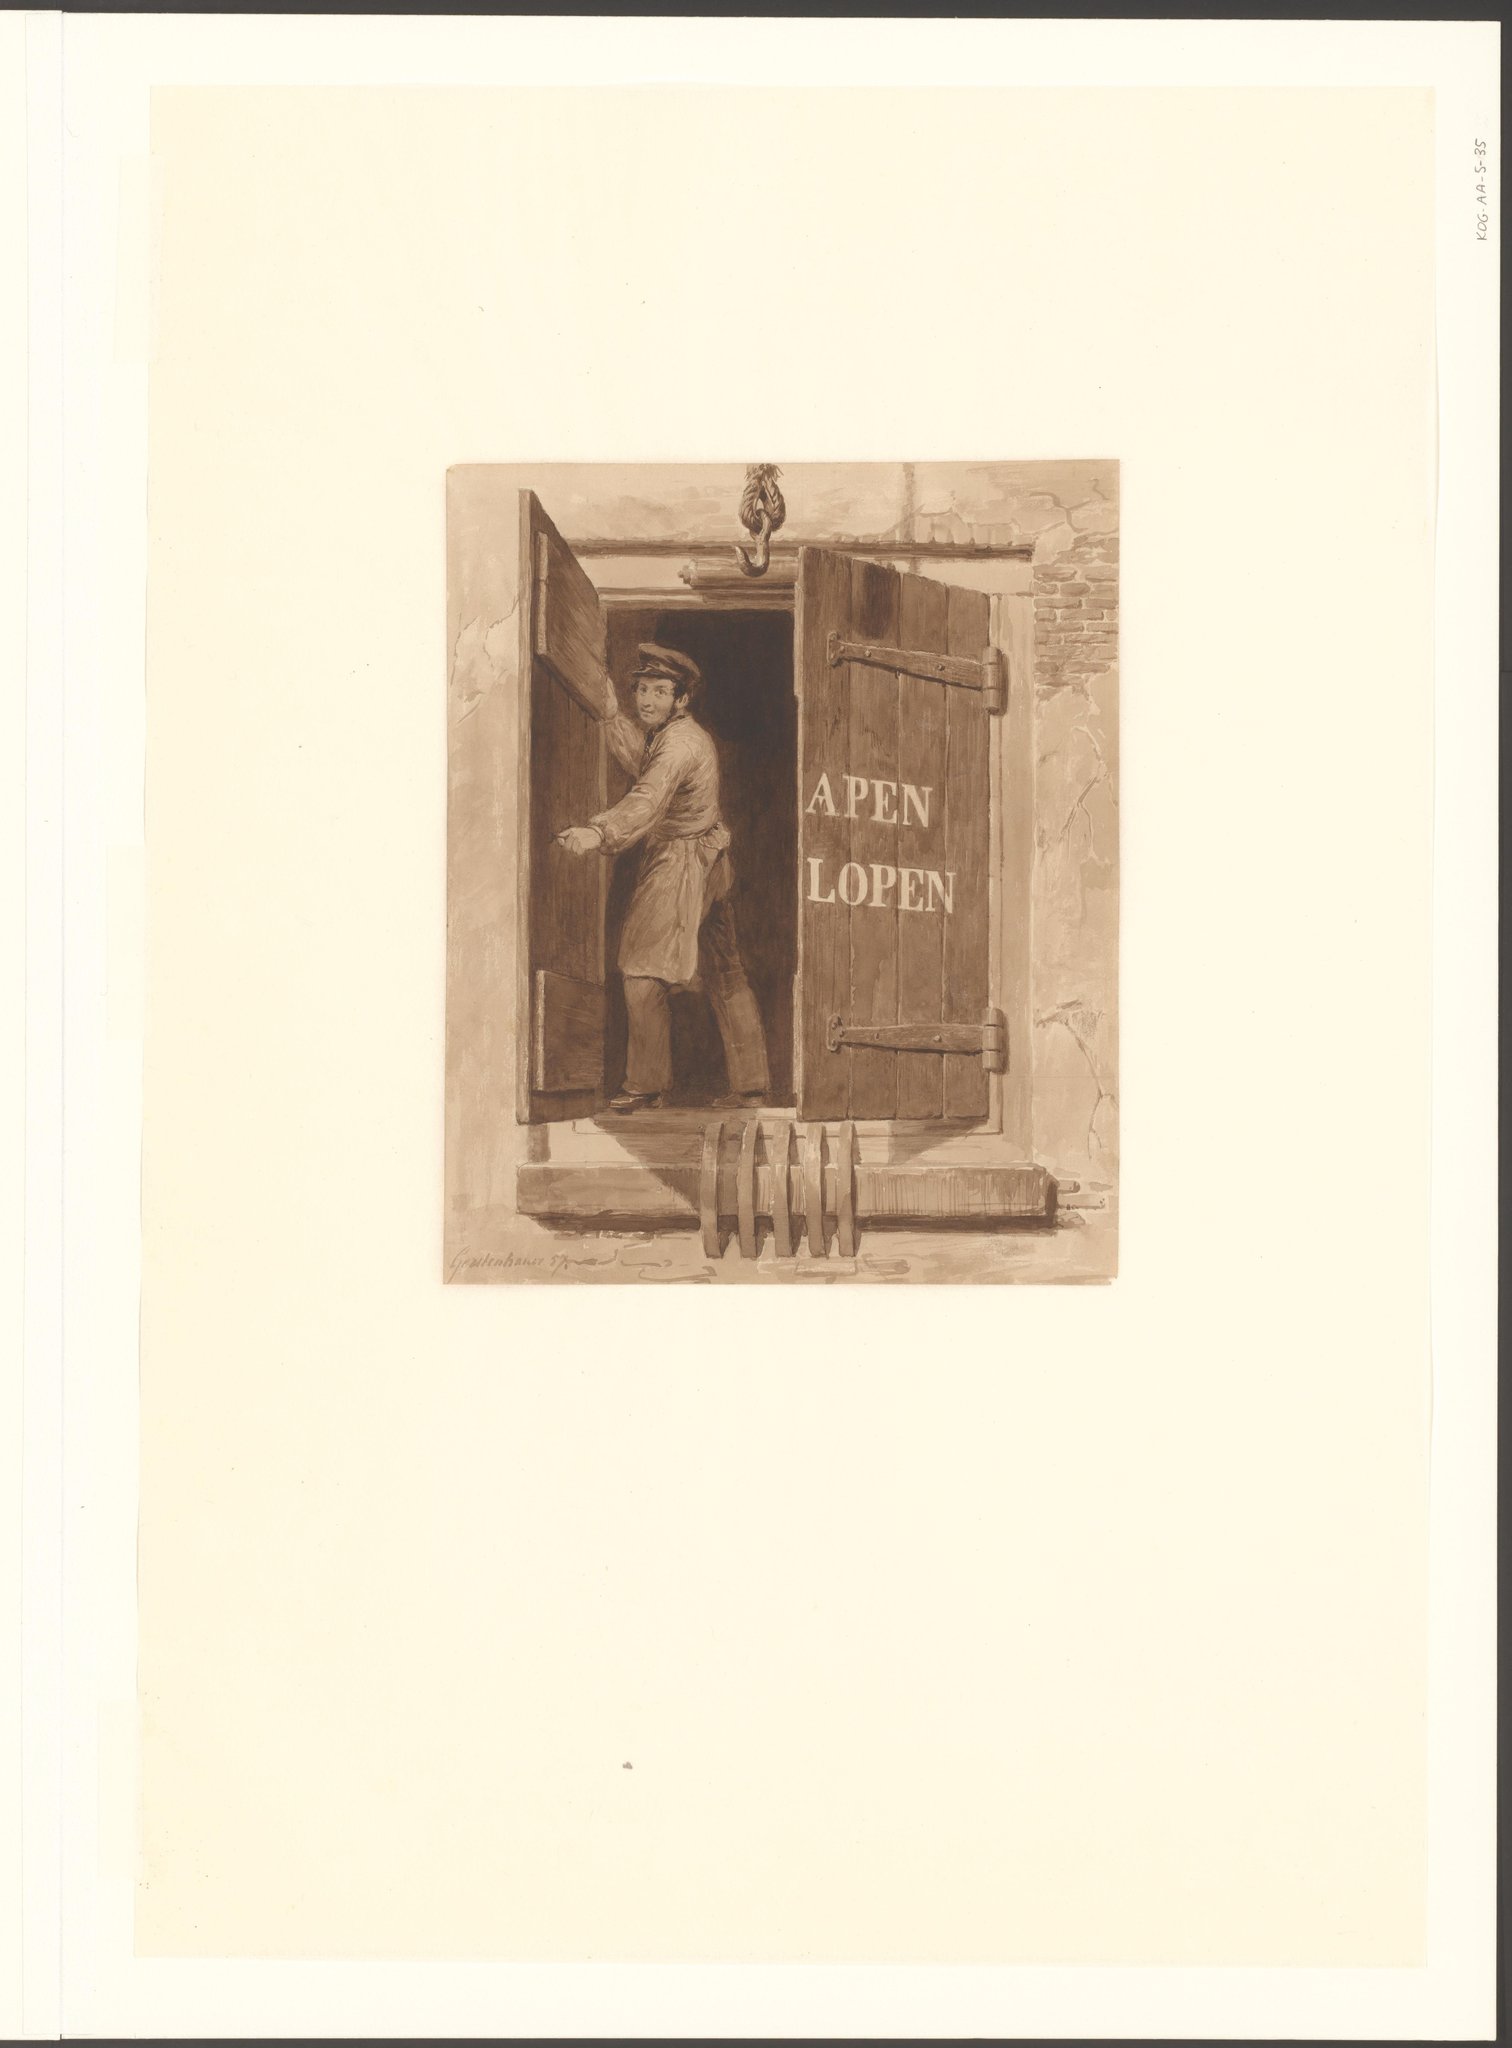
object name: drawing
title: Gezicht op de deuropening van het pakhuis Het Wapen van Hindelopen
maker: jan wendel gerstenhauer zimmerman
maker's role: draughtsman, print maker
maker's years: 1816-1887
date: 1857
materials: ink, paper, pencil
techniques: brush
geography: amsterdam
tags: large-scale structure for storage, e.g.: warehouse, depot, silo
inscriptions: inscription: ‘Het pakhuis het Wapen van Hinlopen / in de Haarlemmer Houttuinen.’, number: ‘25’, signature and date: ‘Gerstenhauer 57.’